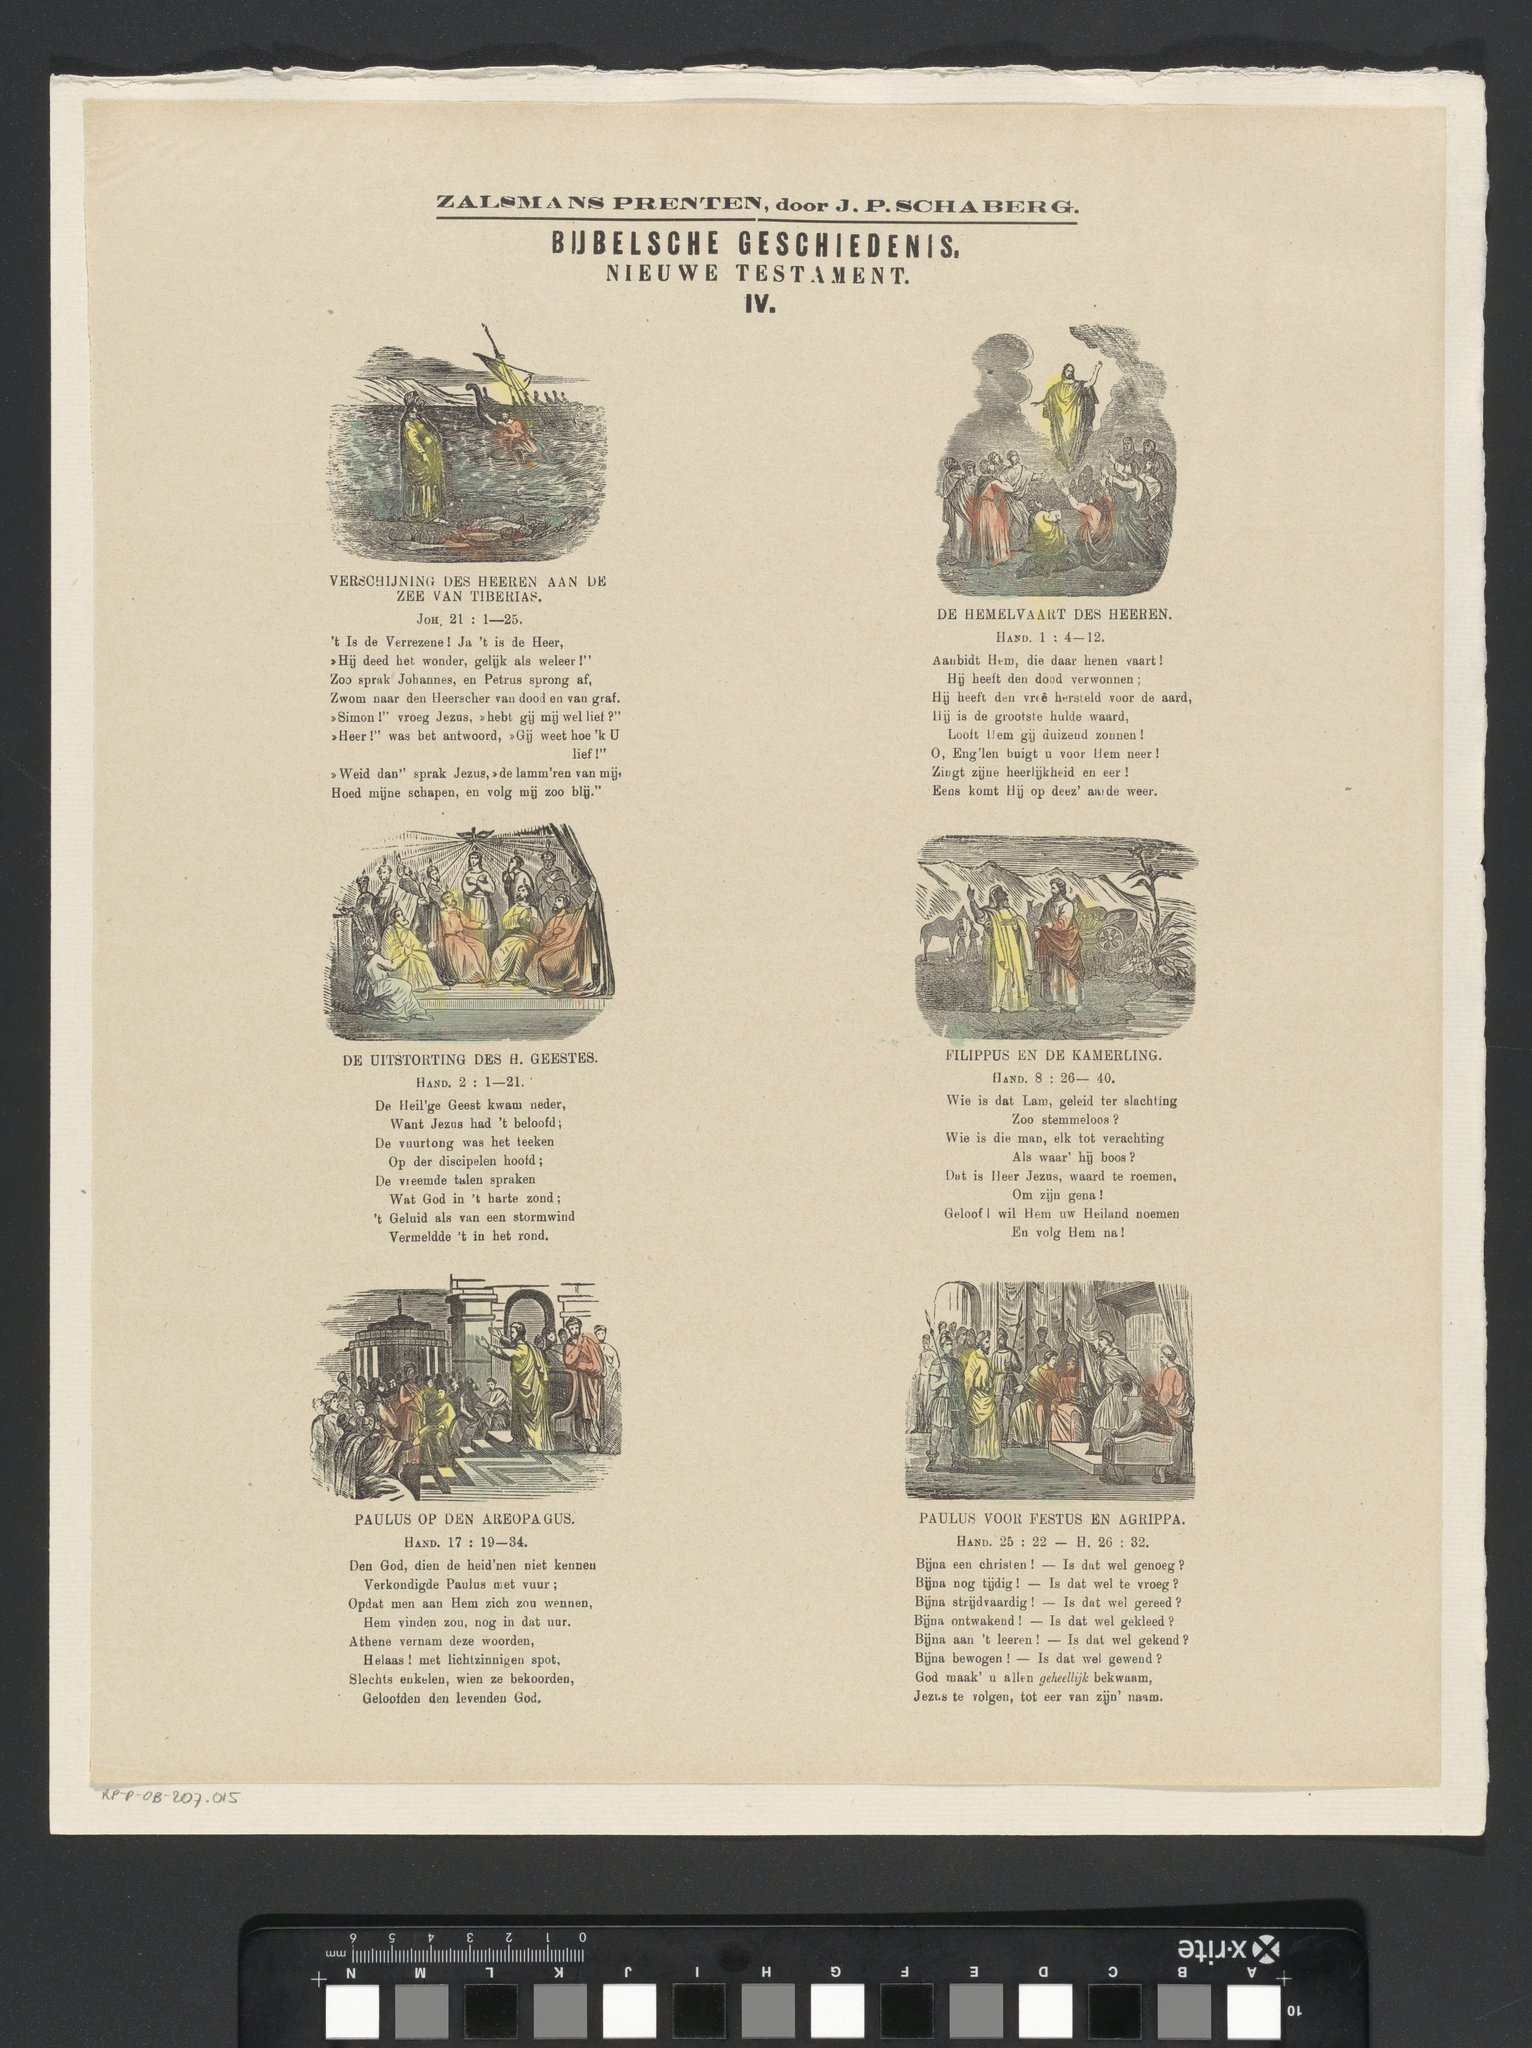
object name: print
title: Bijbelsche geschiedenis / Nieuwe Testament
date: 1869-1882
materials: paper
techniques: colour, letterpress printing, engraving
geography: europe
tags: new testament, series of scenes from the life of christ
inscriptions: collector's mark: Lugt 2760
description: Blad met 6 voorstellingen van verhalen uit het Nieuwe Testament. Onder elke voorstelling een achtregelig vers en een verwijzing naar de bijbehorende Bijbeltekst. Genummerd midden boven: IV.